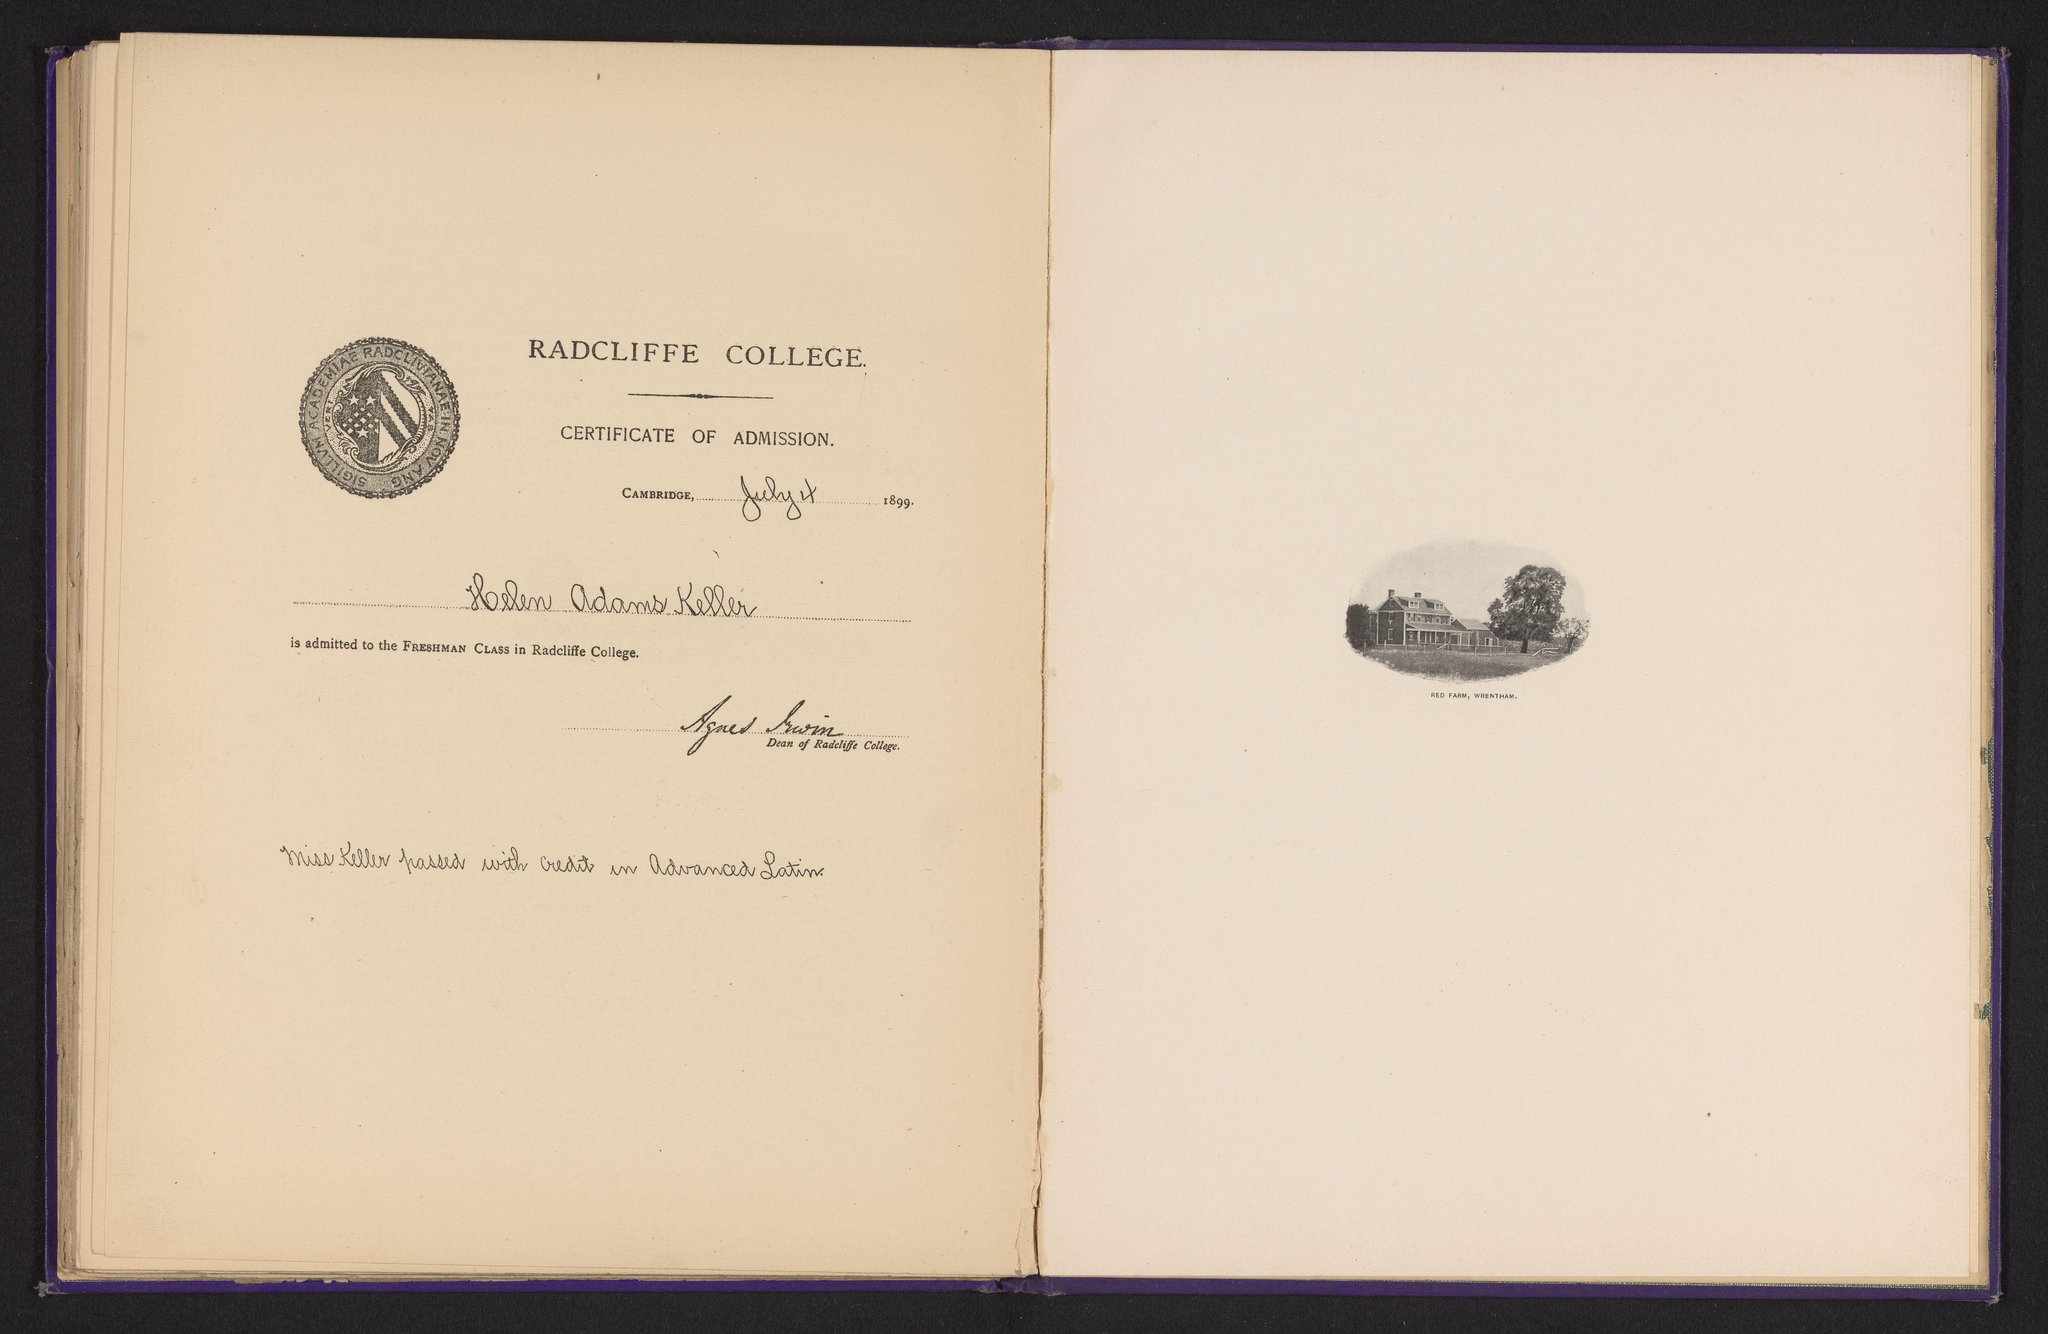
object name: photomechanical print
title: Gezicht op Red Farm in Wrentham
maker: Anonymous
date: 1888-1899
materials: paper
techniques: autotype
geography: massachusetts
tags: farm (building)